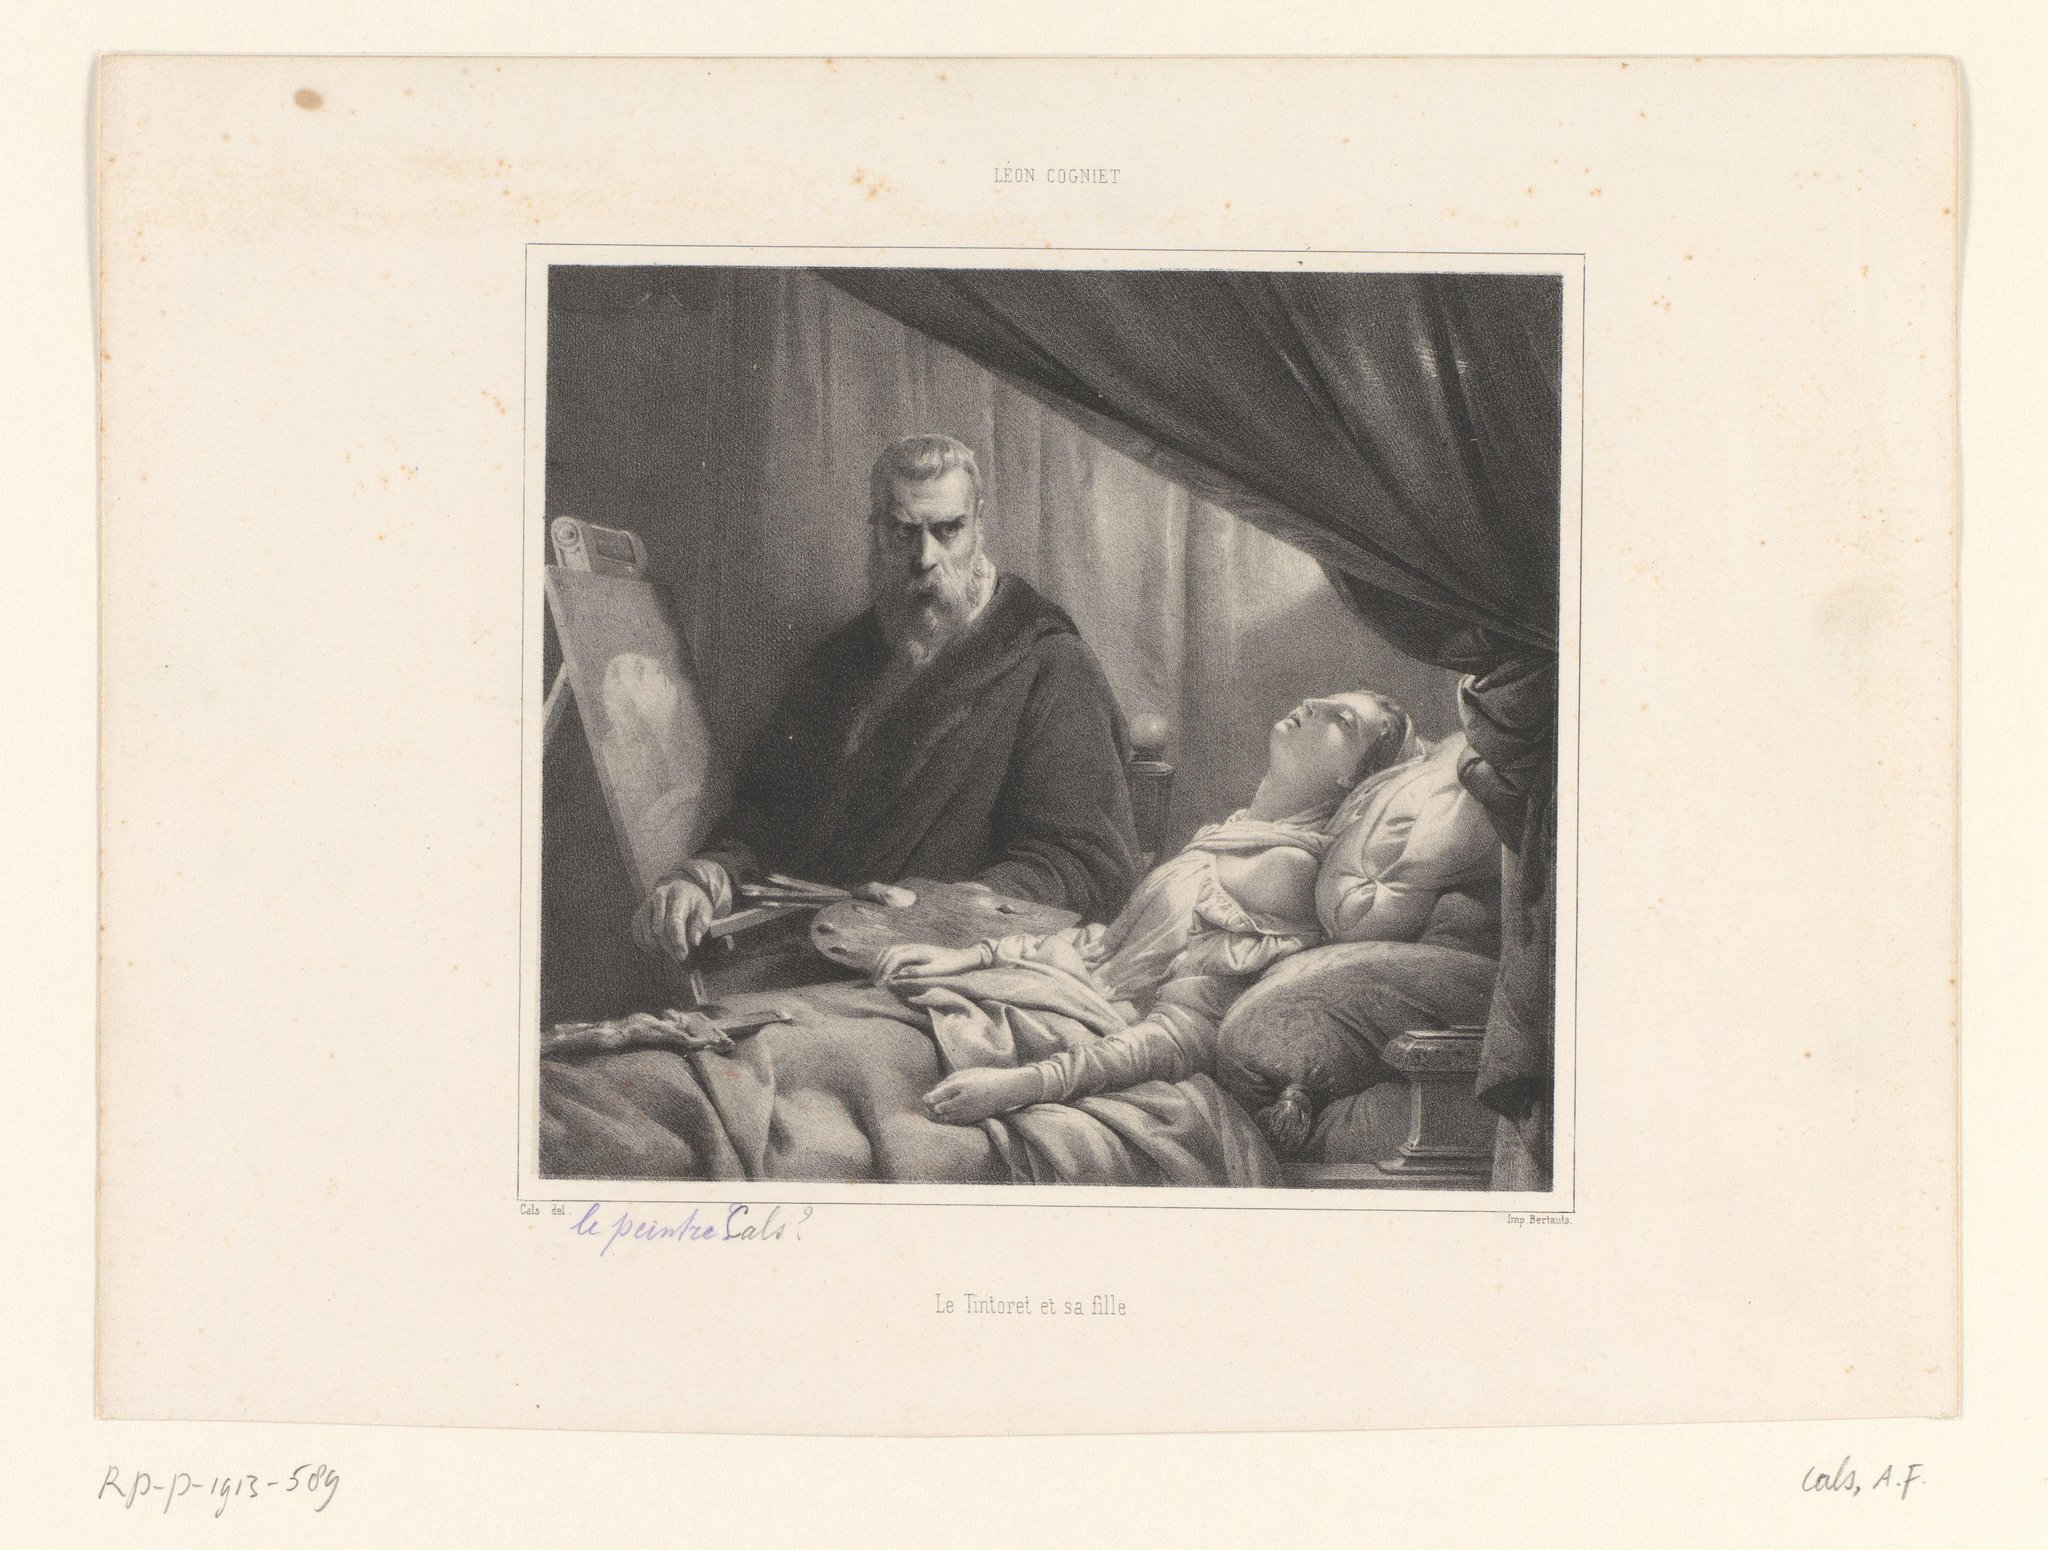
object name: print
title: Tintoretto schildert zijn dochter op haar doodsbed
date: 1843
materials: paper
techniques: lithograph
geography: paris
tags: father and daughter(s) (family group), painter working from live model, deathbed, the corpse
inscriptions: collector's mark: Lugt 2233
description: Prent gepubliceerd in: Léon Curmer, 'Les Beaux-Arts. Illustrations des Arts et de la Littérature', deel I, Parijs 1843, pl. 361.